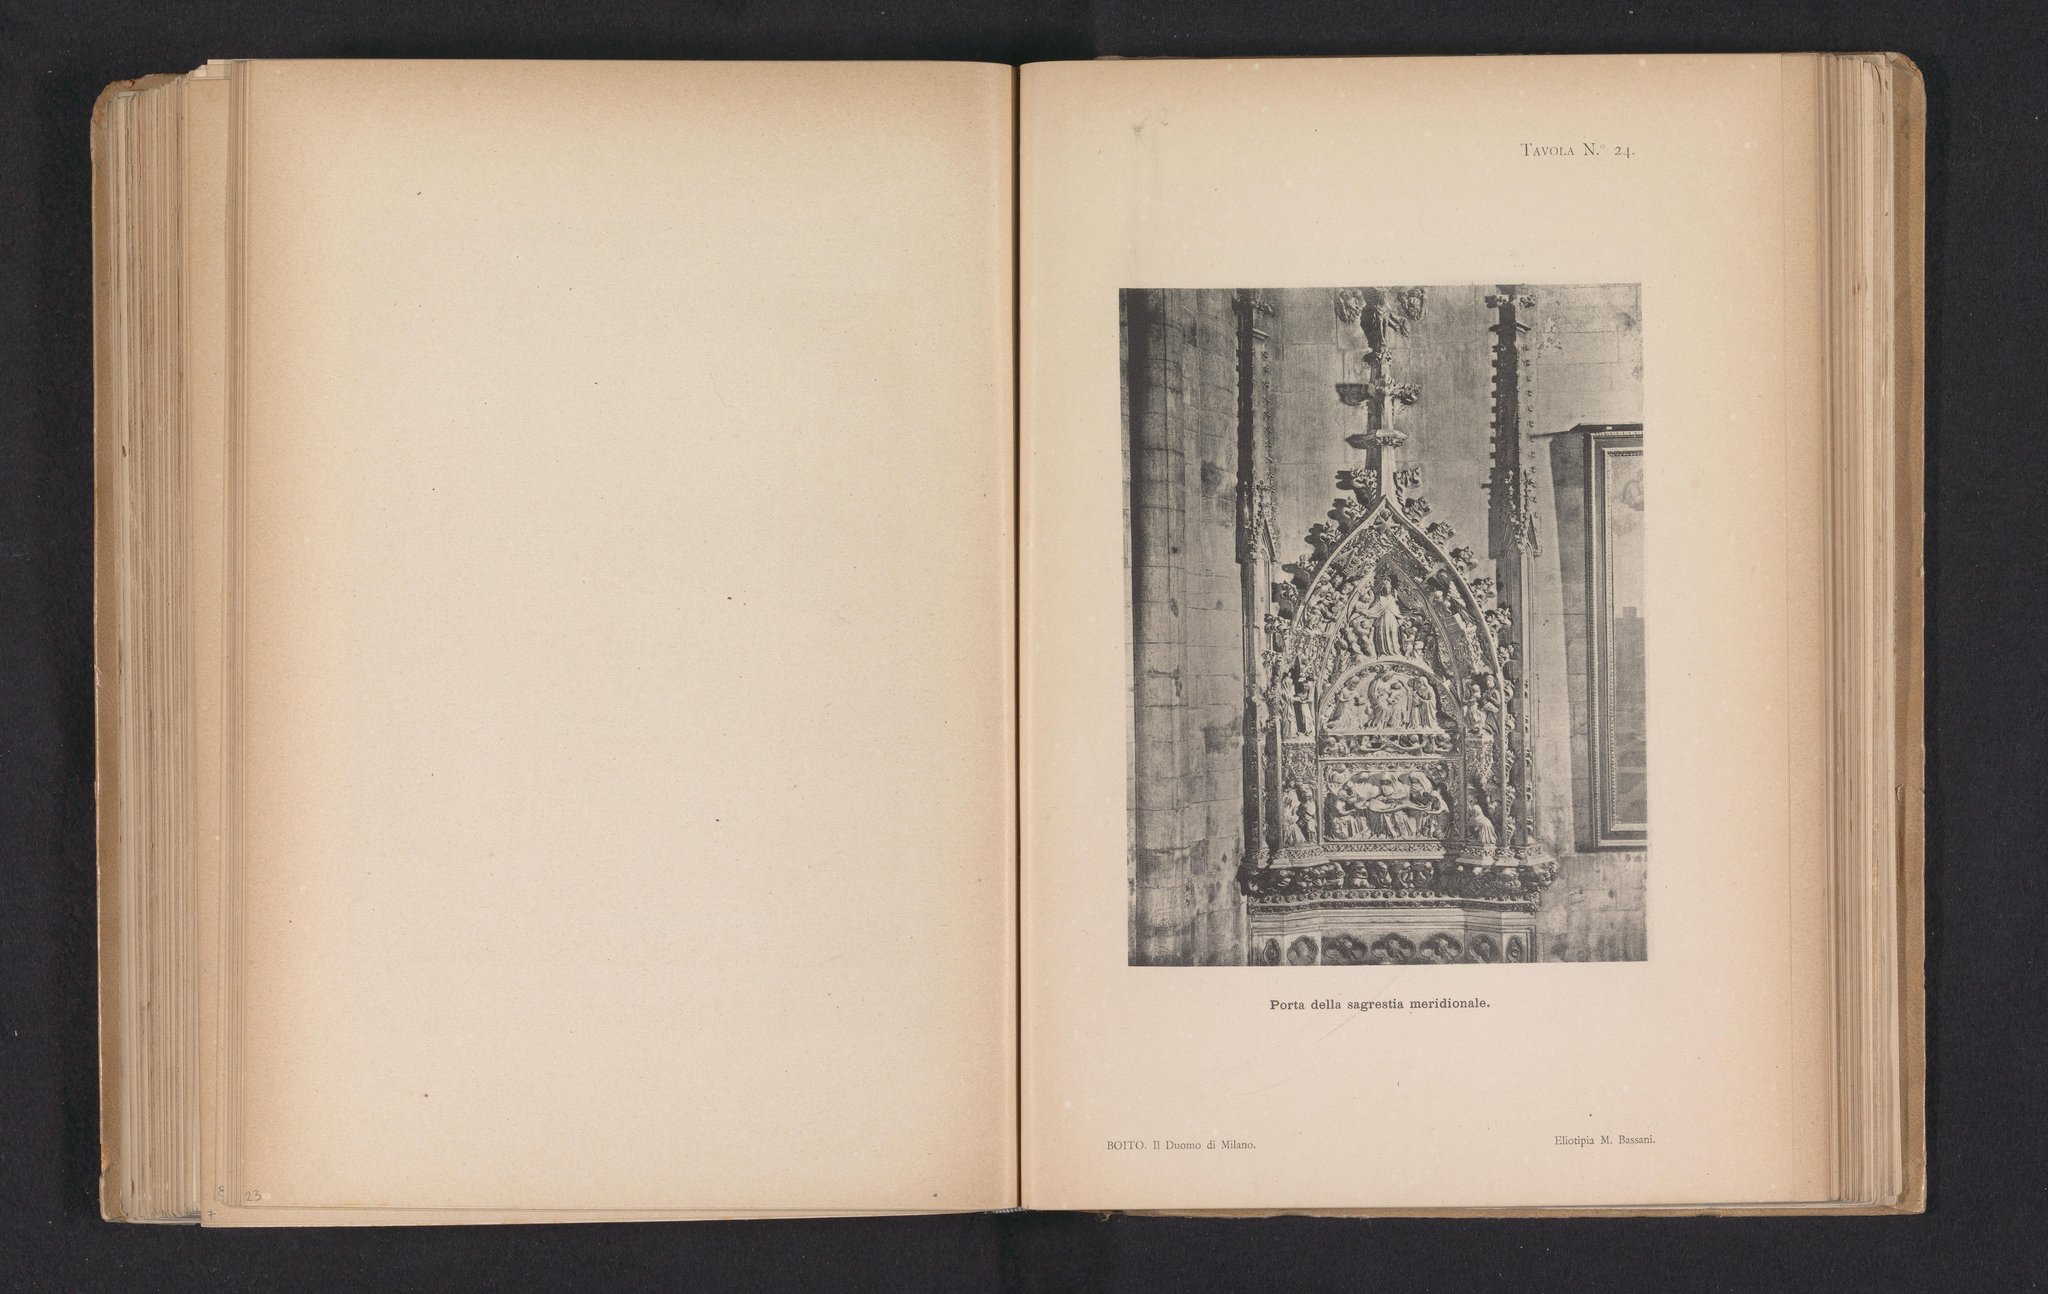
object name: photomechanical print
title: Porta della sagrestia meridionale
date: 1879-1889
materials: paper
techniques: photograph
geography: milan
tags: parts of church interior: sacristy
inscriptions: number: ‘Tavola No. 24.’